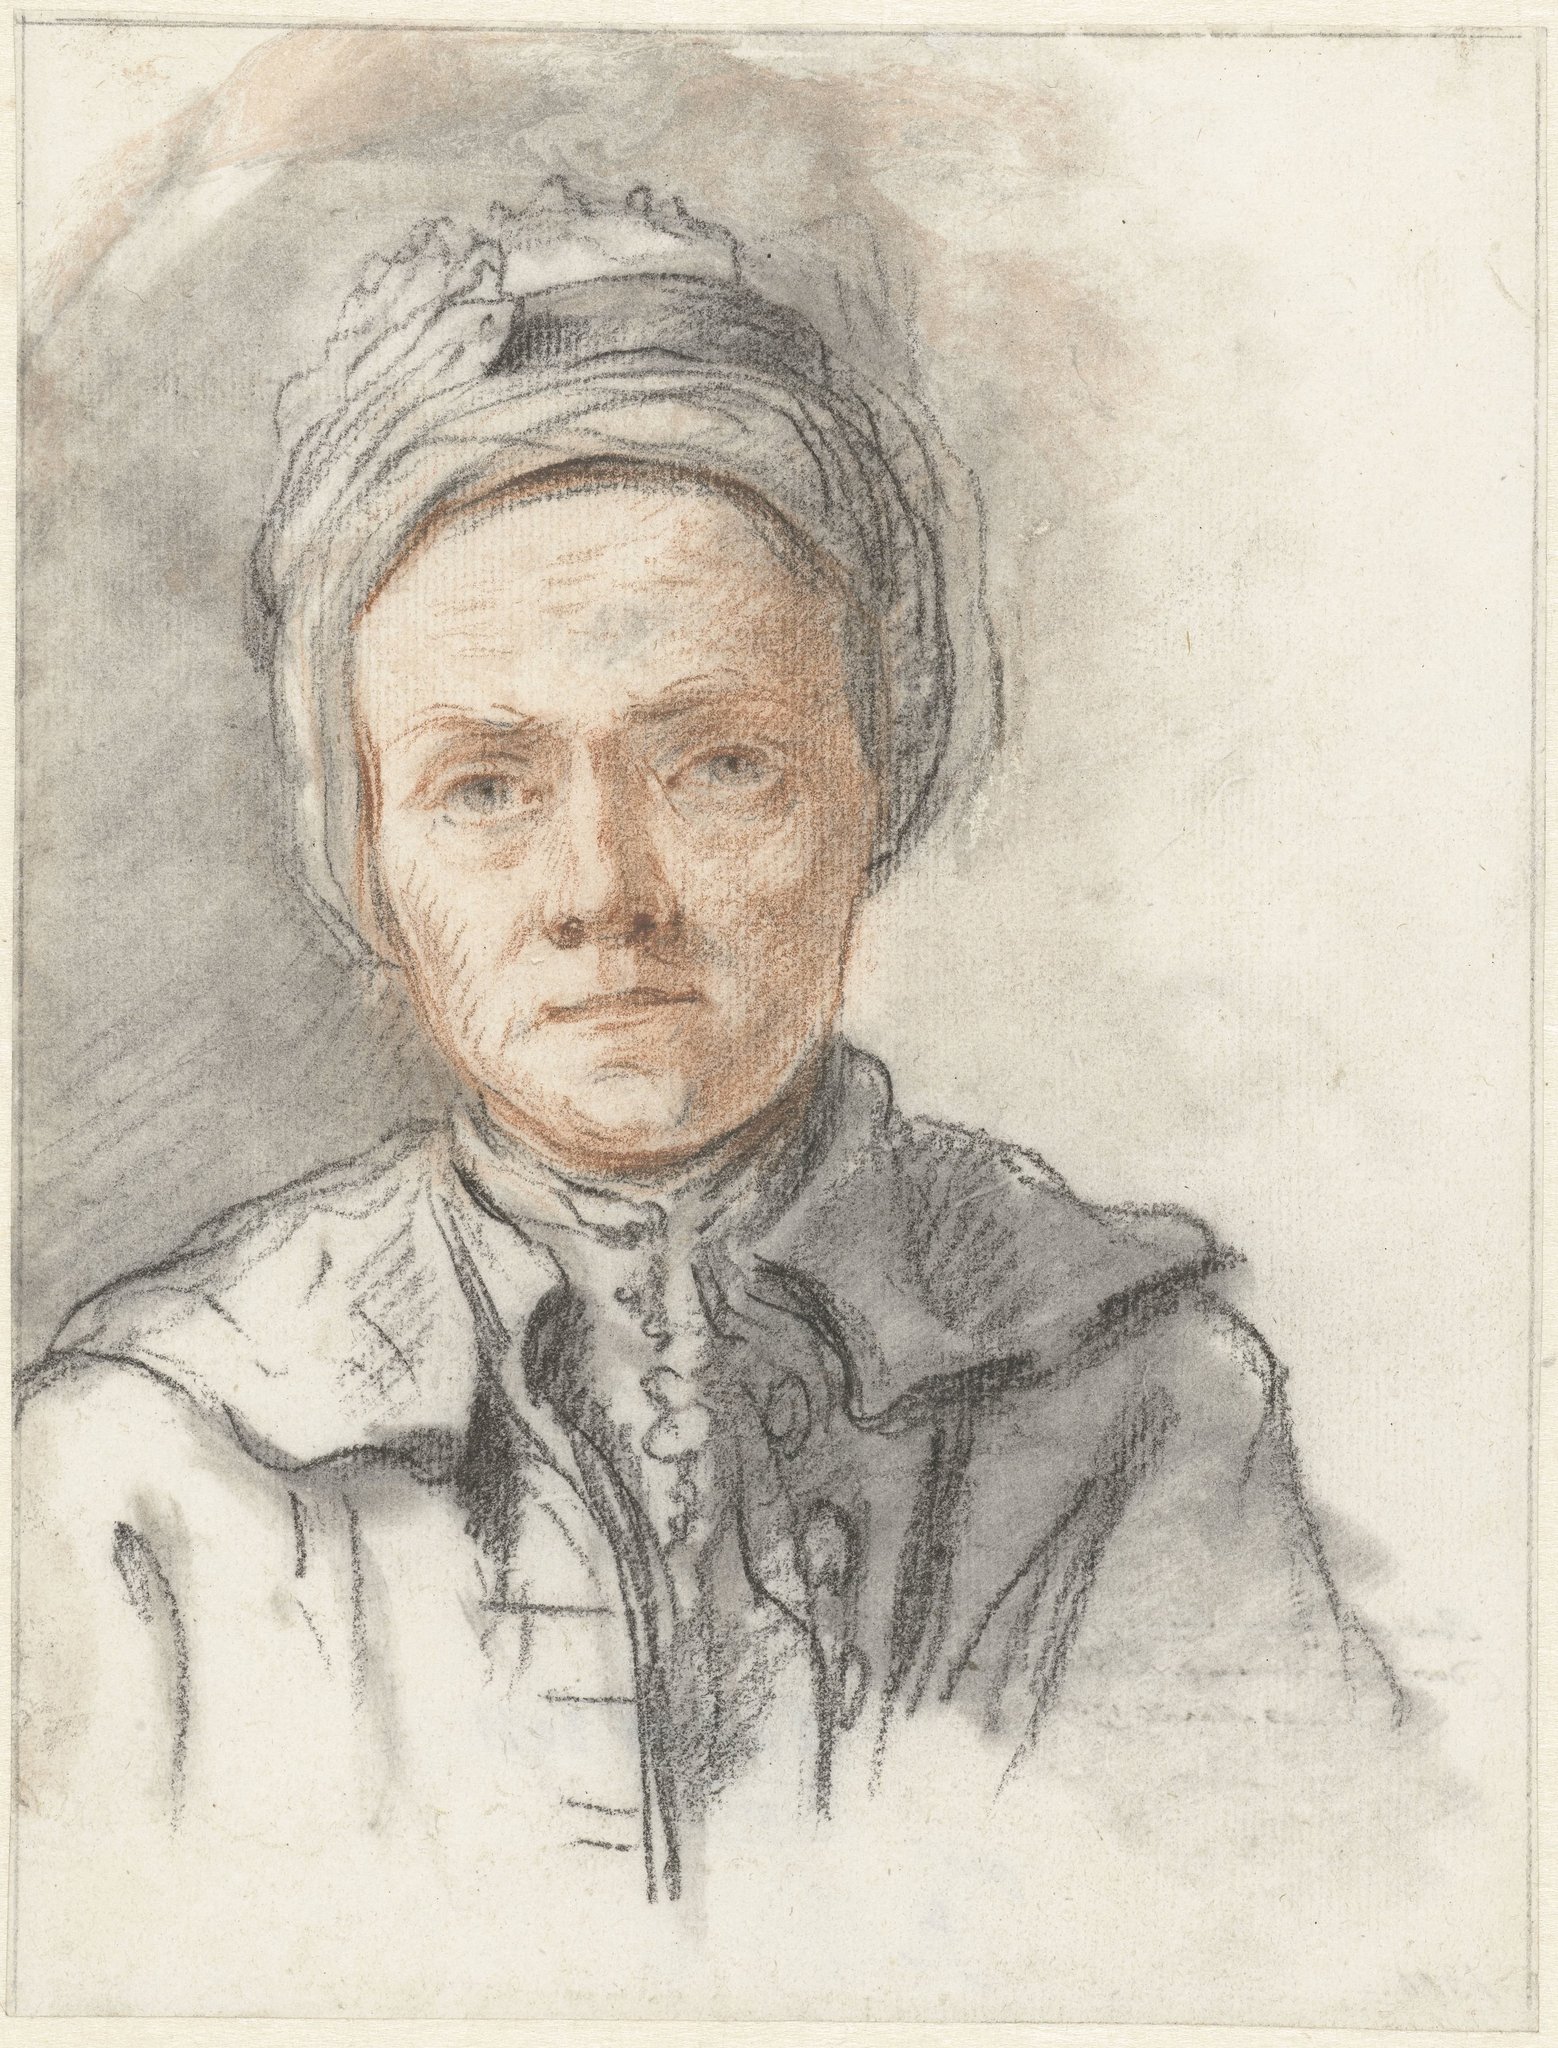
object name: drawing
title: Portret van de tekenaar Jacob Cats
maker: reinier vinkeles (i)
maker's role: draughtsman, print maker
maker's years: 1741-1816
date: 1799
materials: chalk, paper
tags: amsterdam, print maker, draughtsman, jacob cats (1741-1799), historical persons, portrait, self-portrait of painter, portrait, self-portrait of artist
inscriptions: inscription: ‘Portret van den Teekenaar Jacob Cats / door zijn Vriend, R. Vinkeles vervaardigd / den 23 Maart 1799’